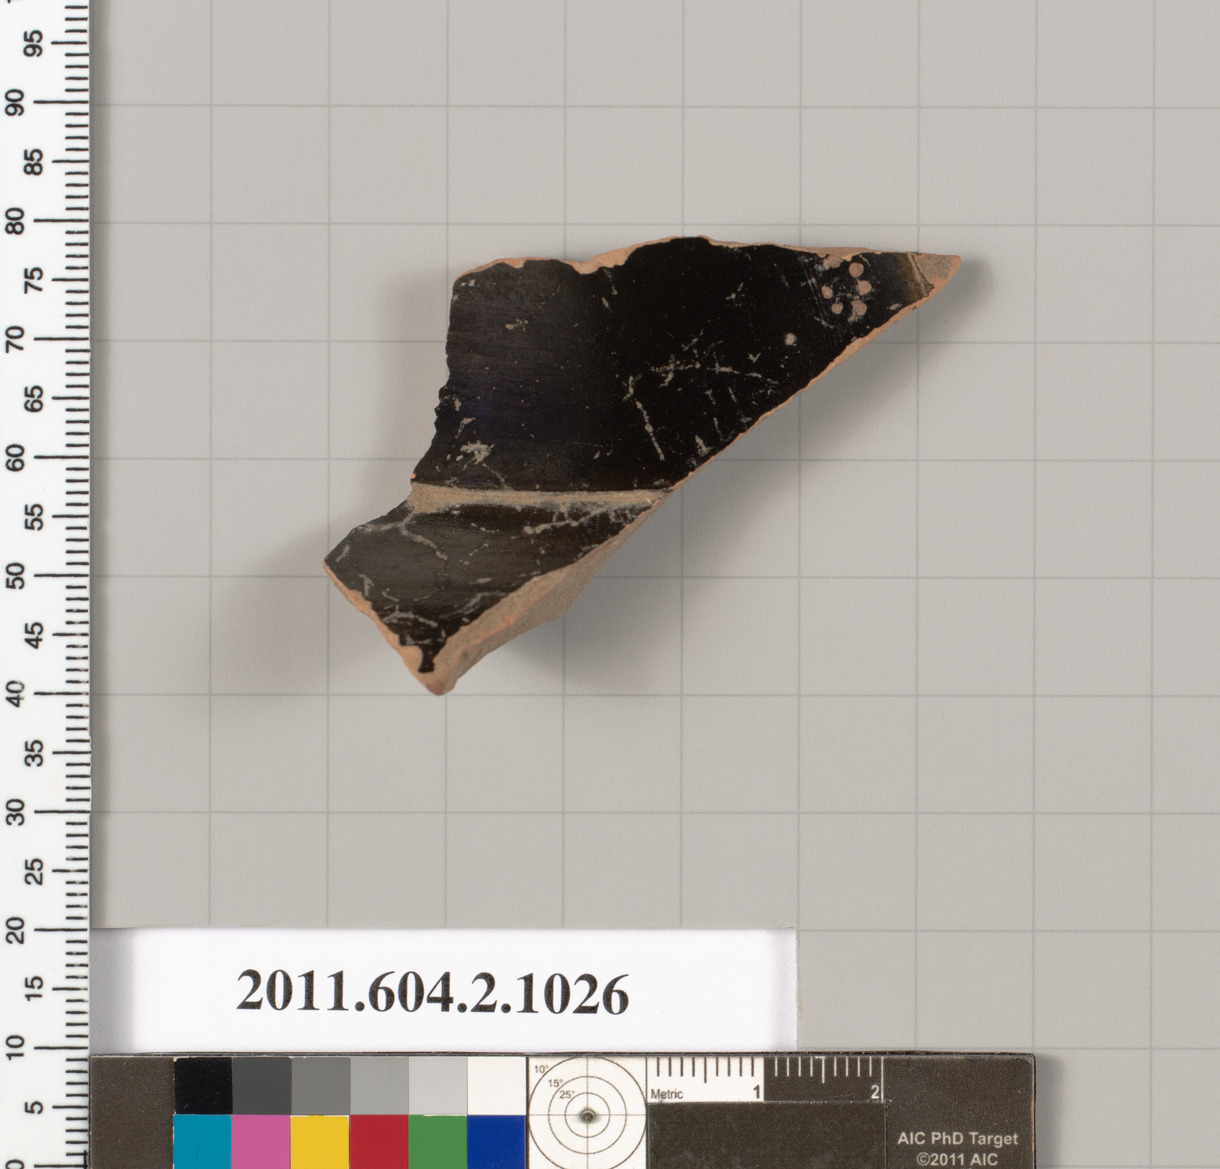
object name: oinochoe fragment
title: Terracotta fragment of an oinochoe (jug)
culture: greek, attic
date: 475-425 BCE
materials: terracotta